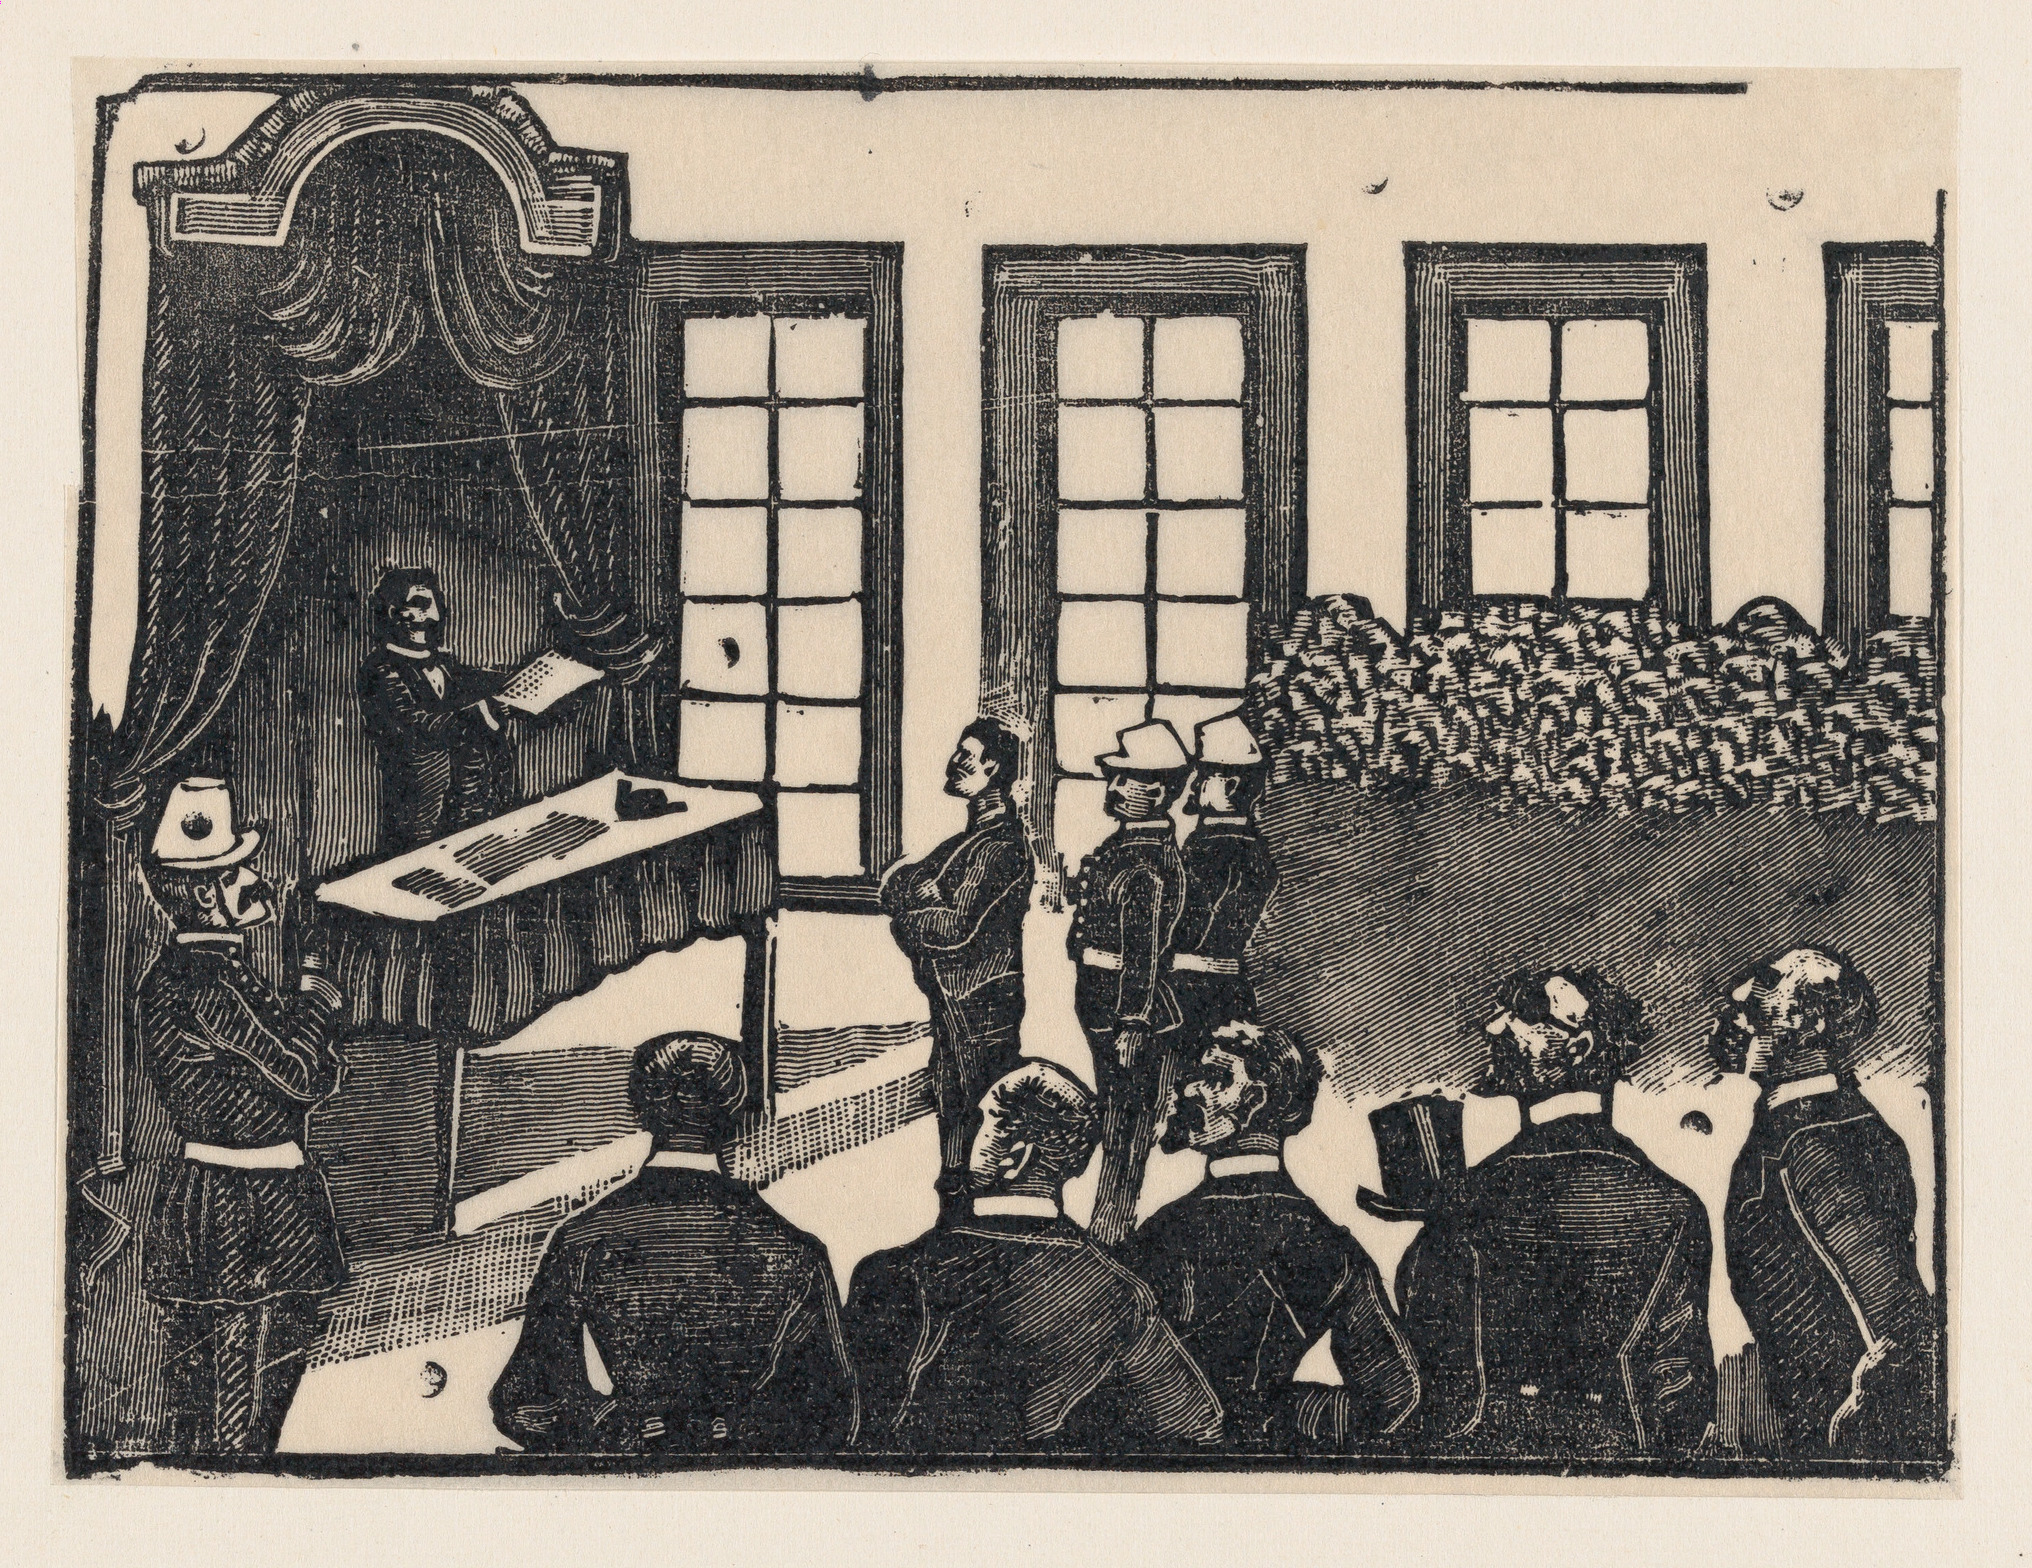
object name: print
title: A courtroom scene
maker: josé guadalupe posada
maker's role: artist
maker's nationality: mexican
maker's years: 1852-1913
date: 1892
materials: metal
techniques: engraving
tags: men,crowd,law